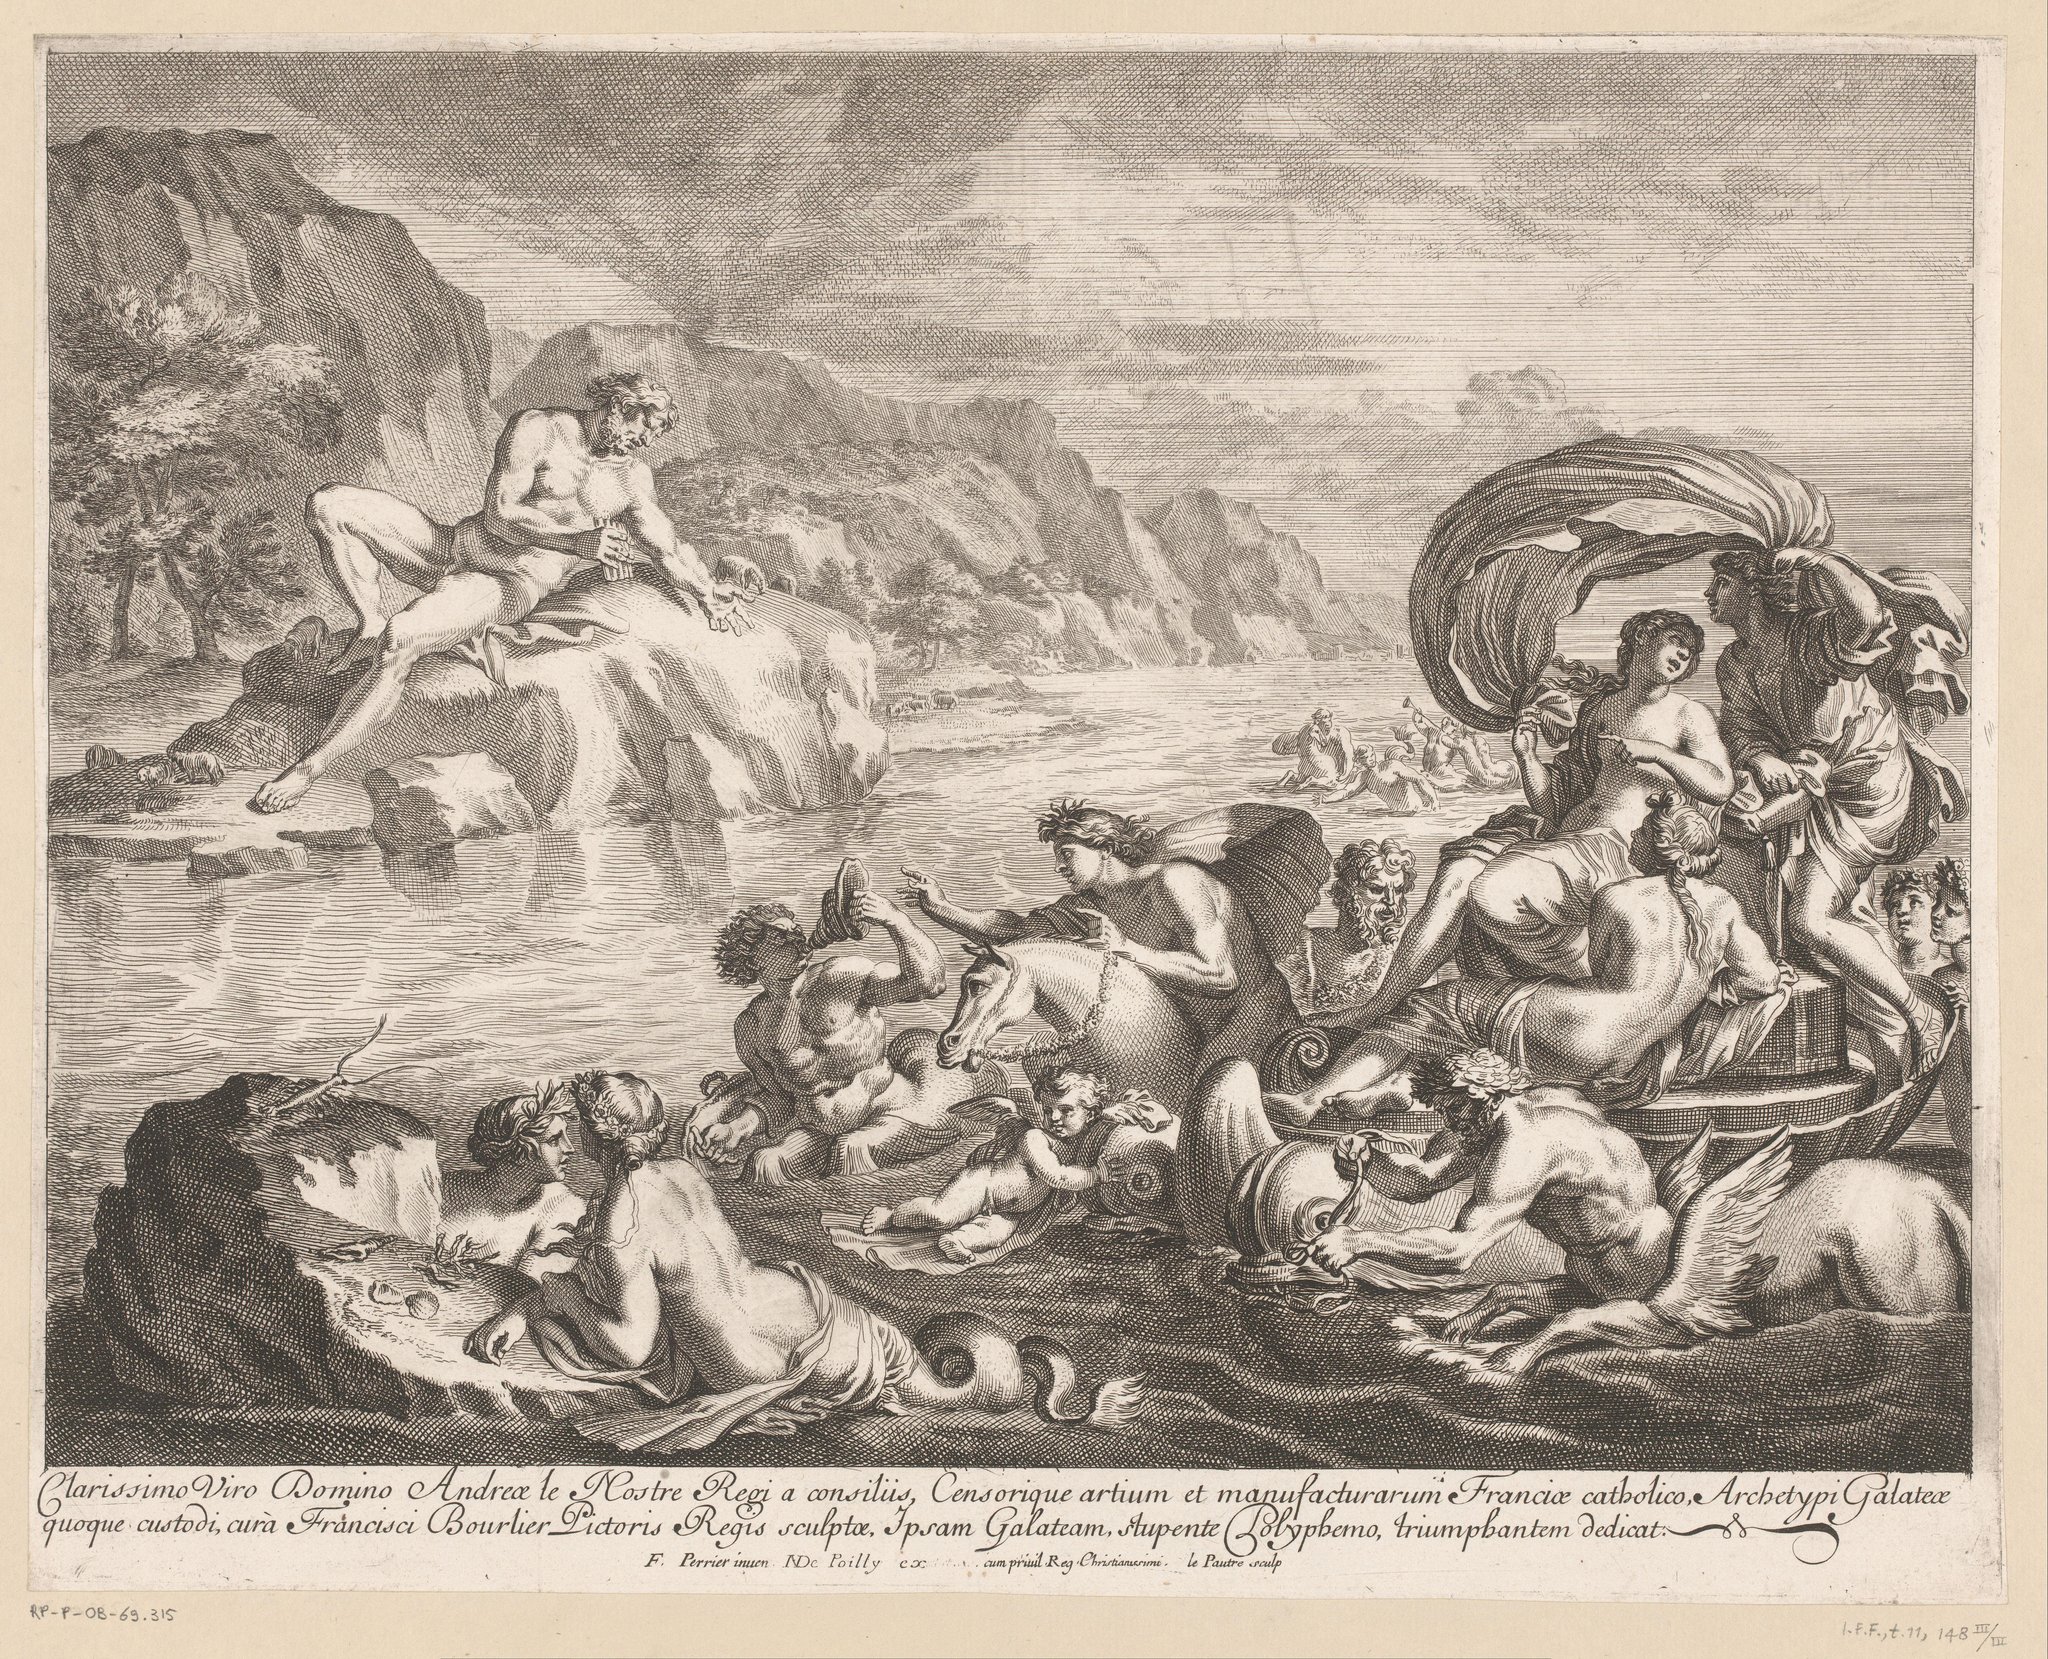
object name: print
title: Triomf van Galatea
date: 1628-1682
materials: paper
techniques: engraving, etching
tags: triumph of galatea, polyphemus playing the syrinx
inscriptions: collector's mark: Lugt 240